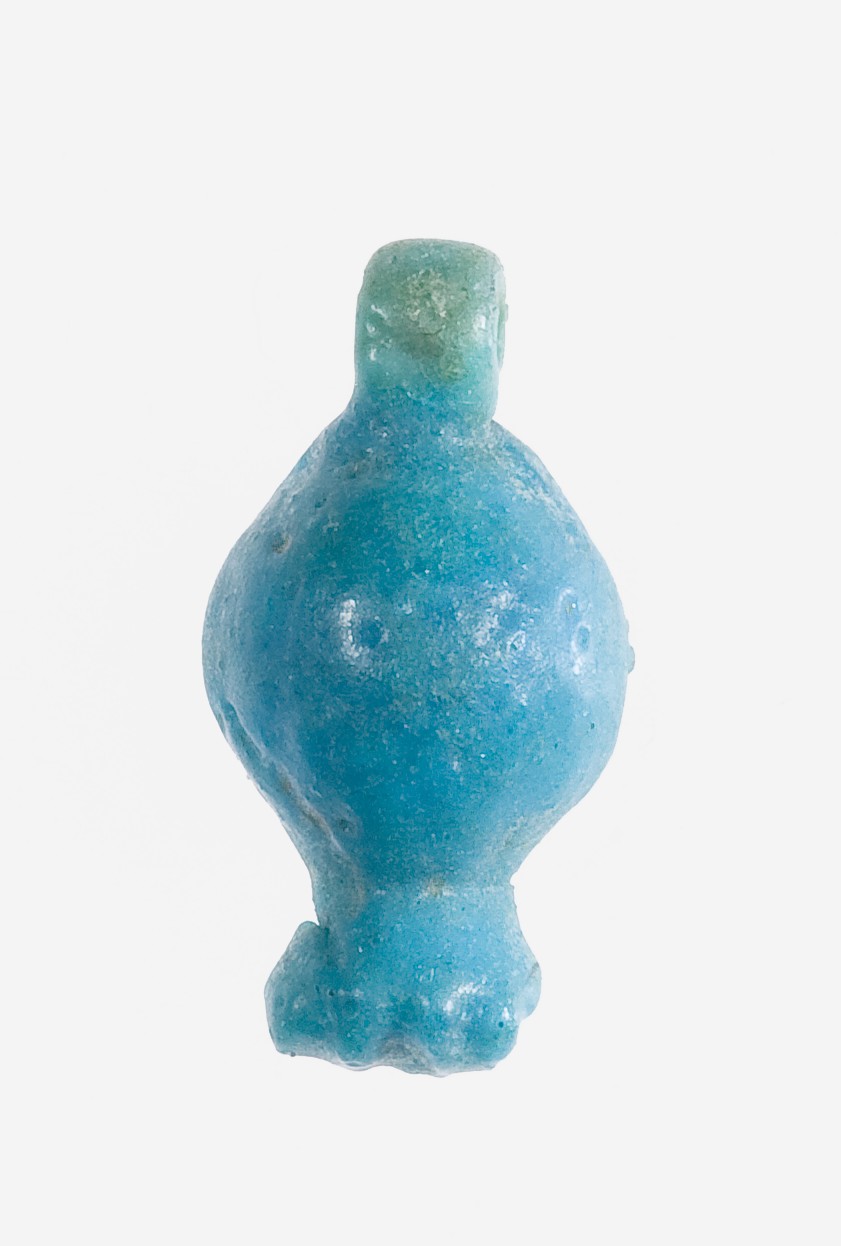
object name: pendant, cornflower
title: Cornflower Pendant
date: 1390-1352 BCE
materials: faience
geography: egypt